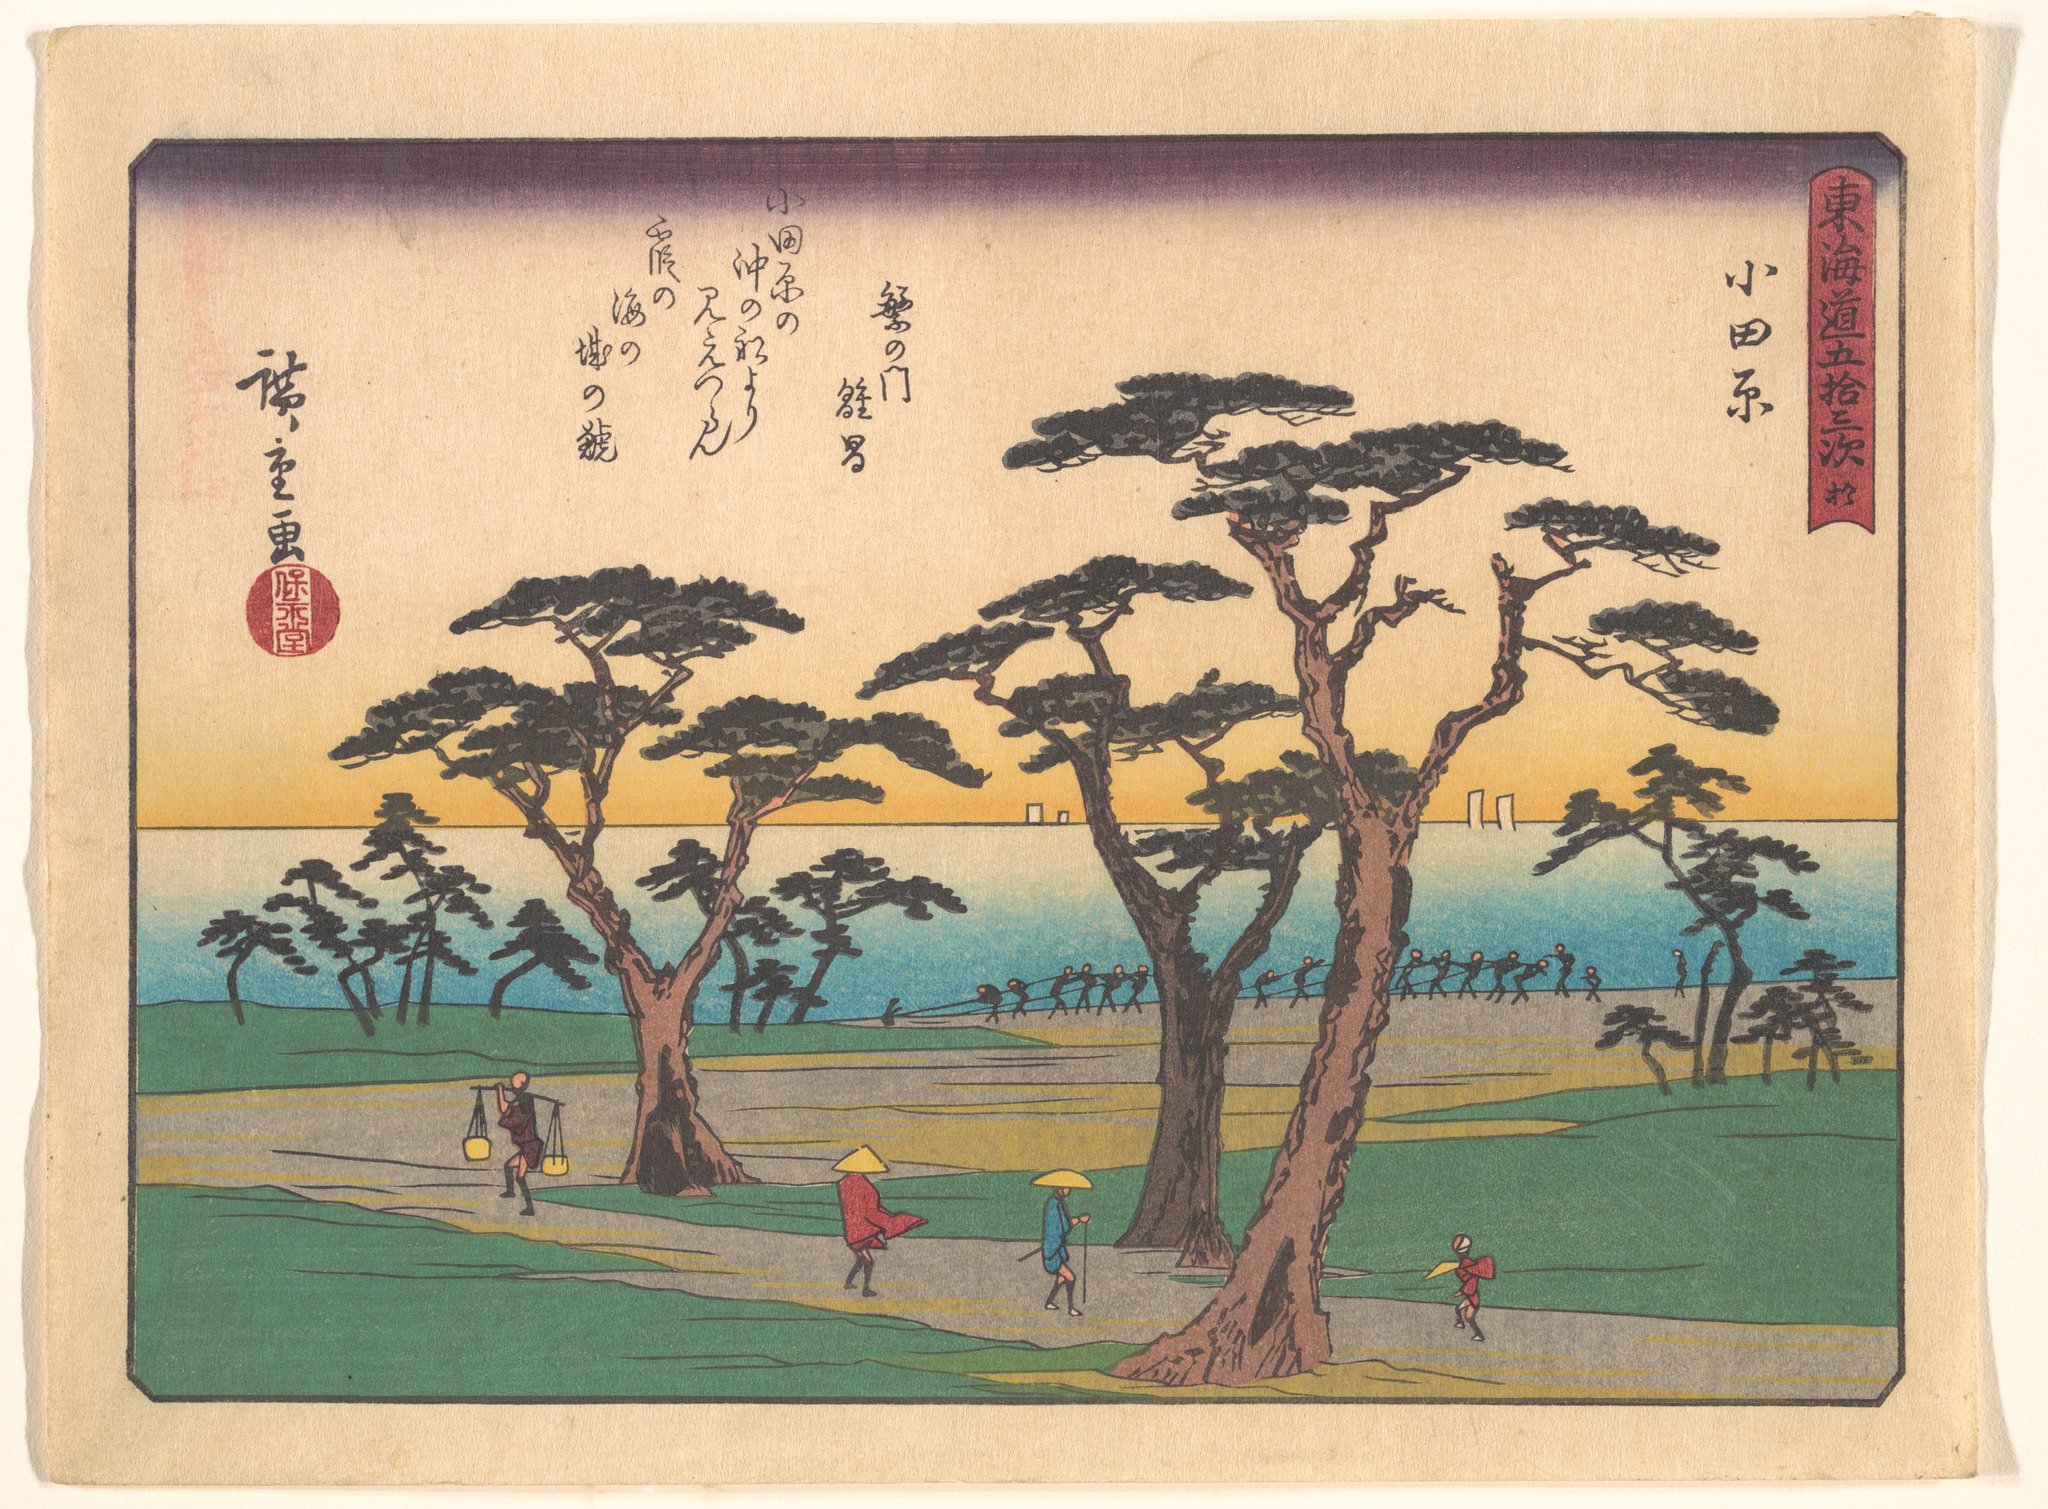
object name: print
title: 東海道五十三次 小田原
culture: japanese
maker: utagawa hiroshige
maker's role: artist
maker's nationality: japanese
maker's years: 1797-1858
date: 1901-1933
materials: ink, paper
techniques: woodblock print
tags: human figures,landscapes,trees